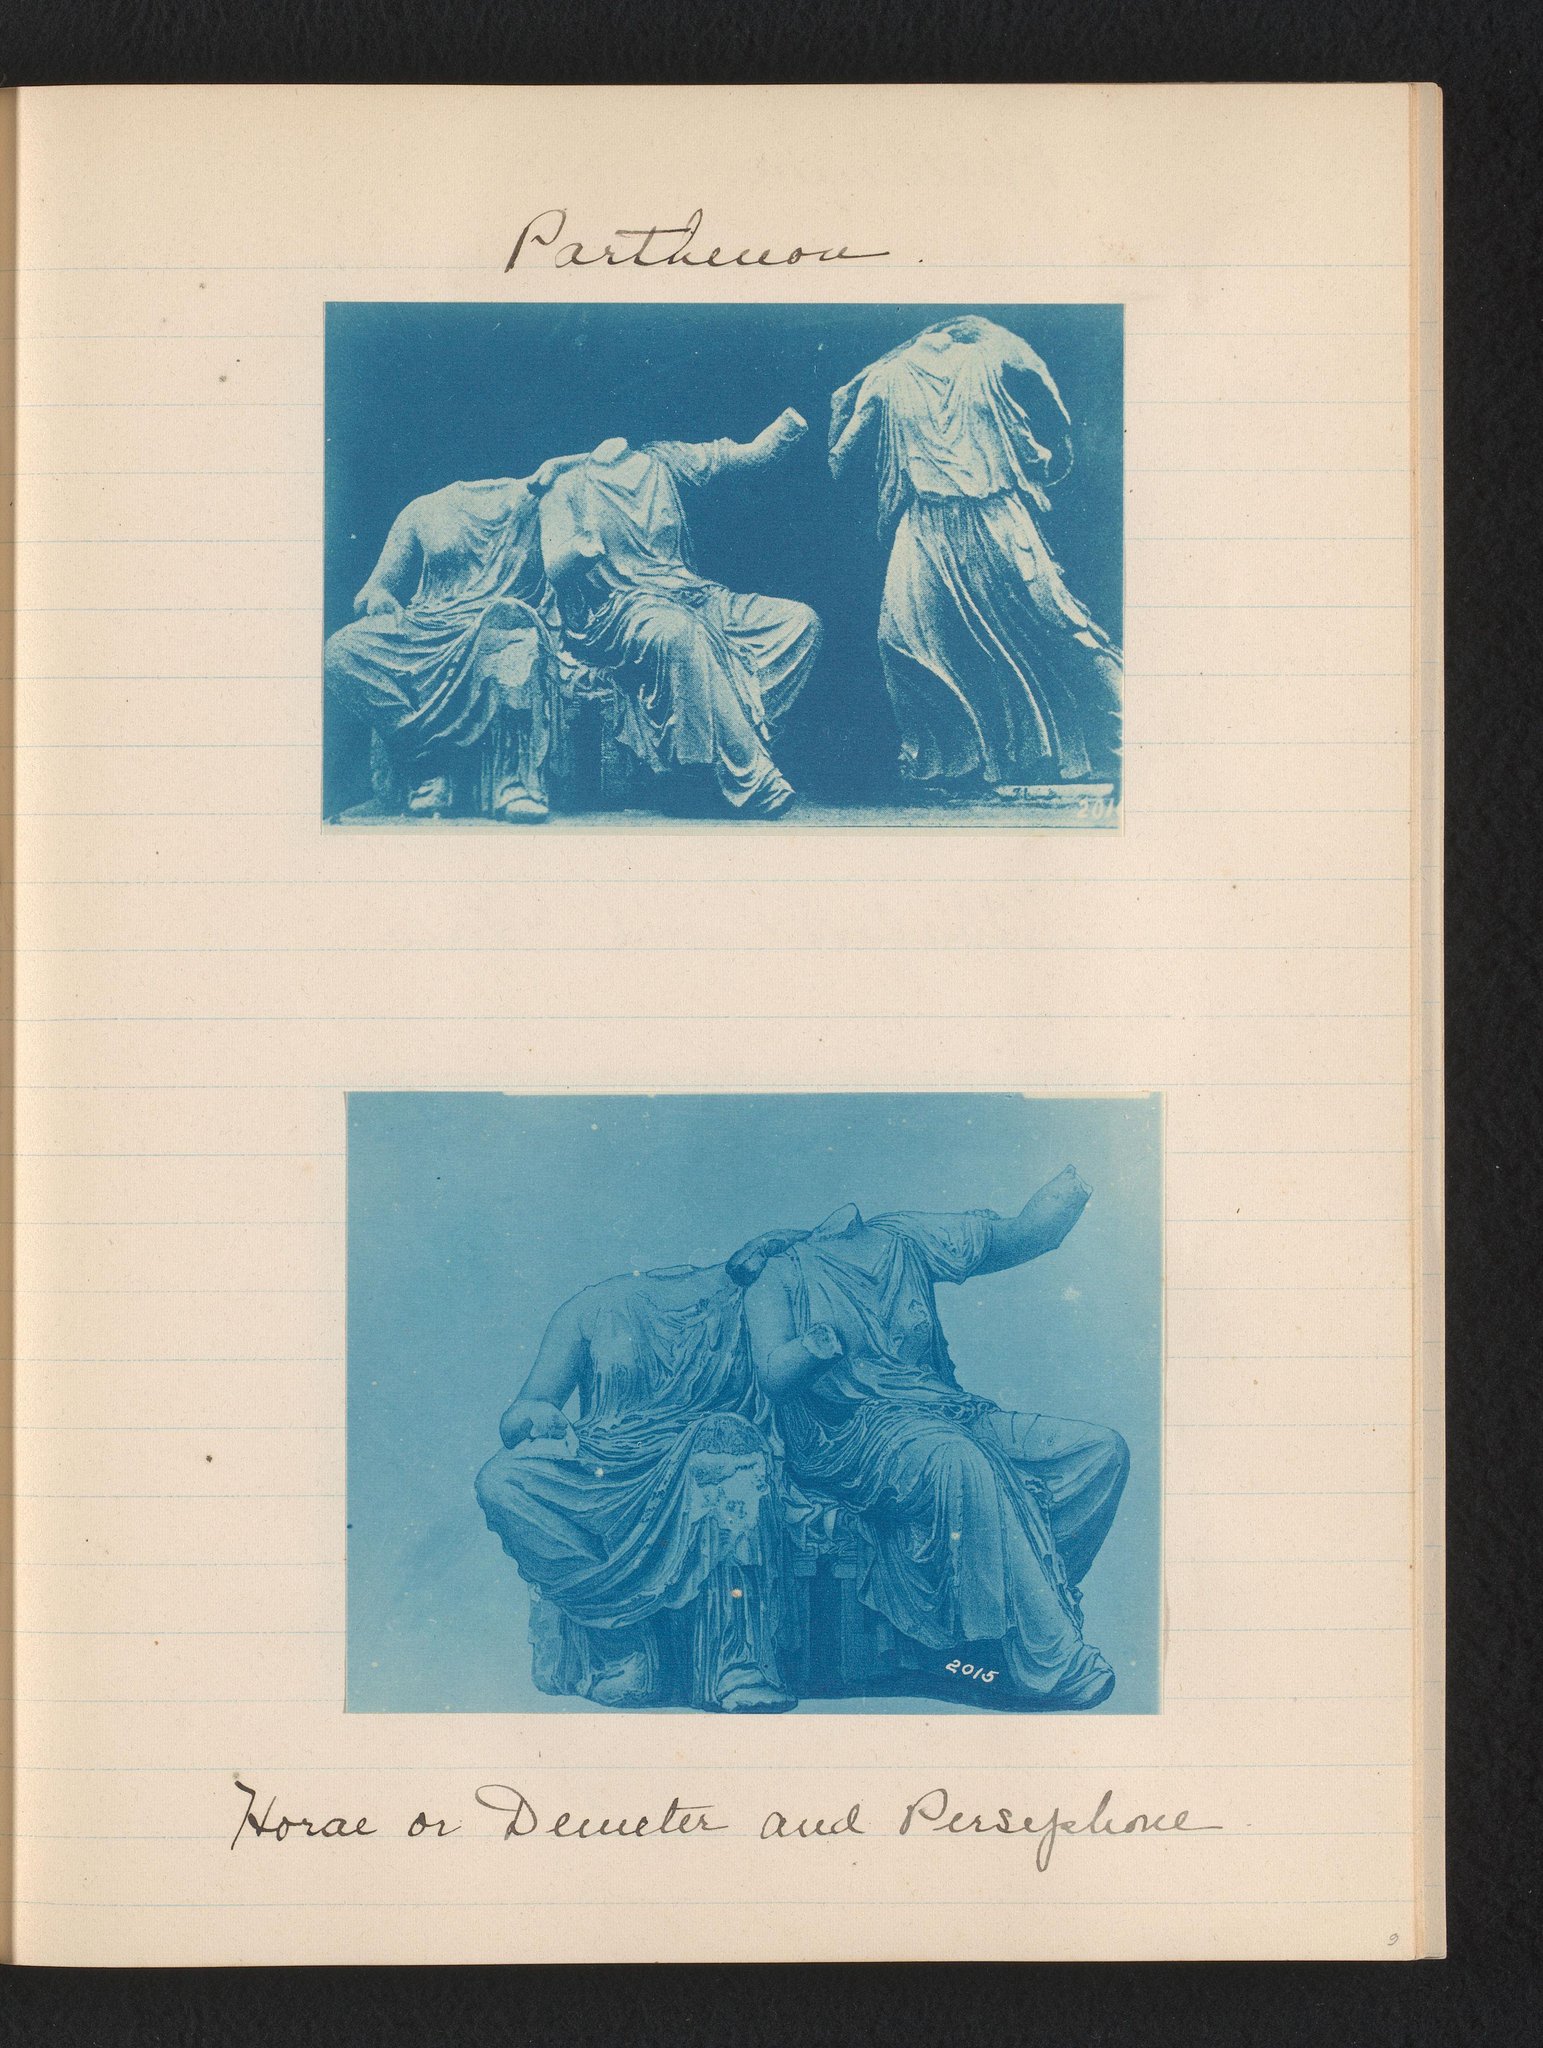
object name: reproduction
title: Foto en een fotoreproductie van een tekening van beelden uit het fries van het Parthenon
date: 1901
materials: paper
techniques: cyanotype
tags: piece of sculpture, reproduction of a piece of sculpture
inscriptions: inscription: ‘Horae or Demeter and Persephone’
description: Deze foto's maken deel uit van een album.